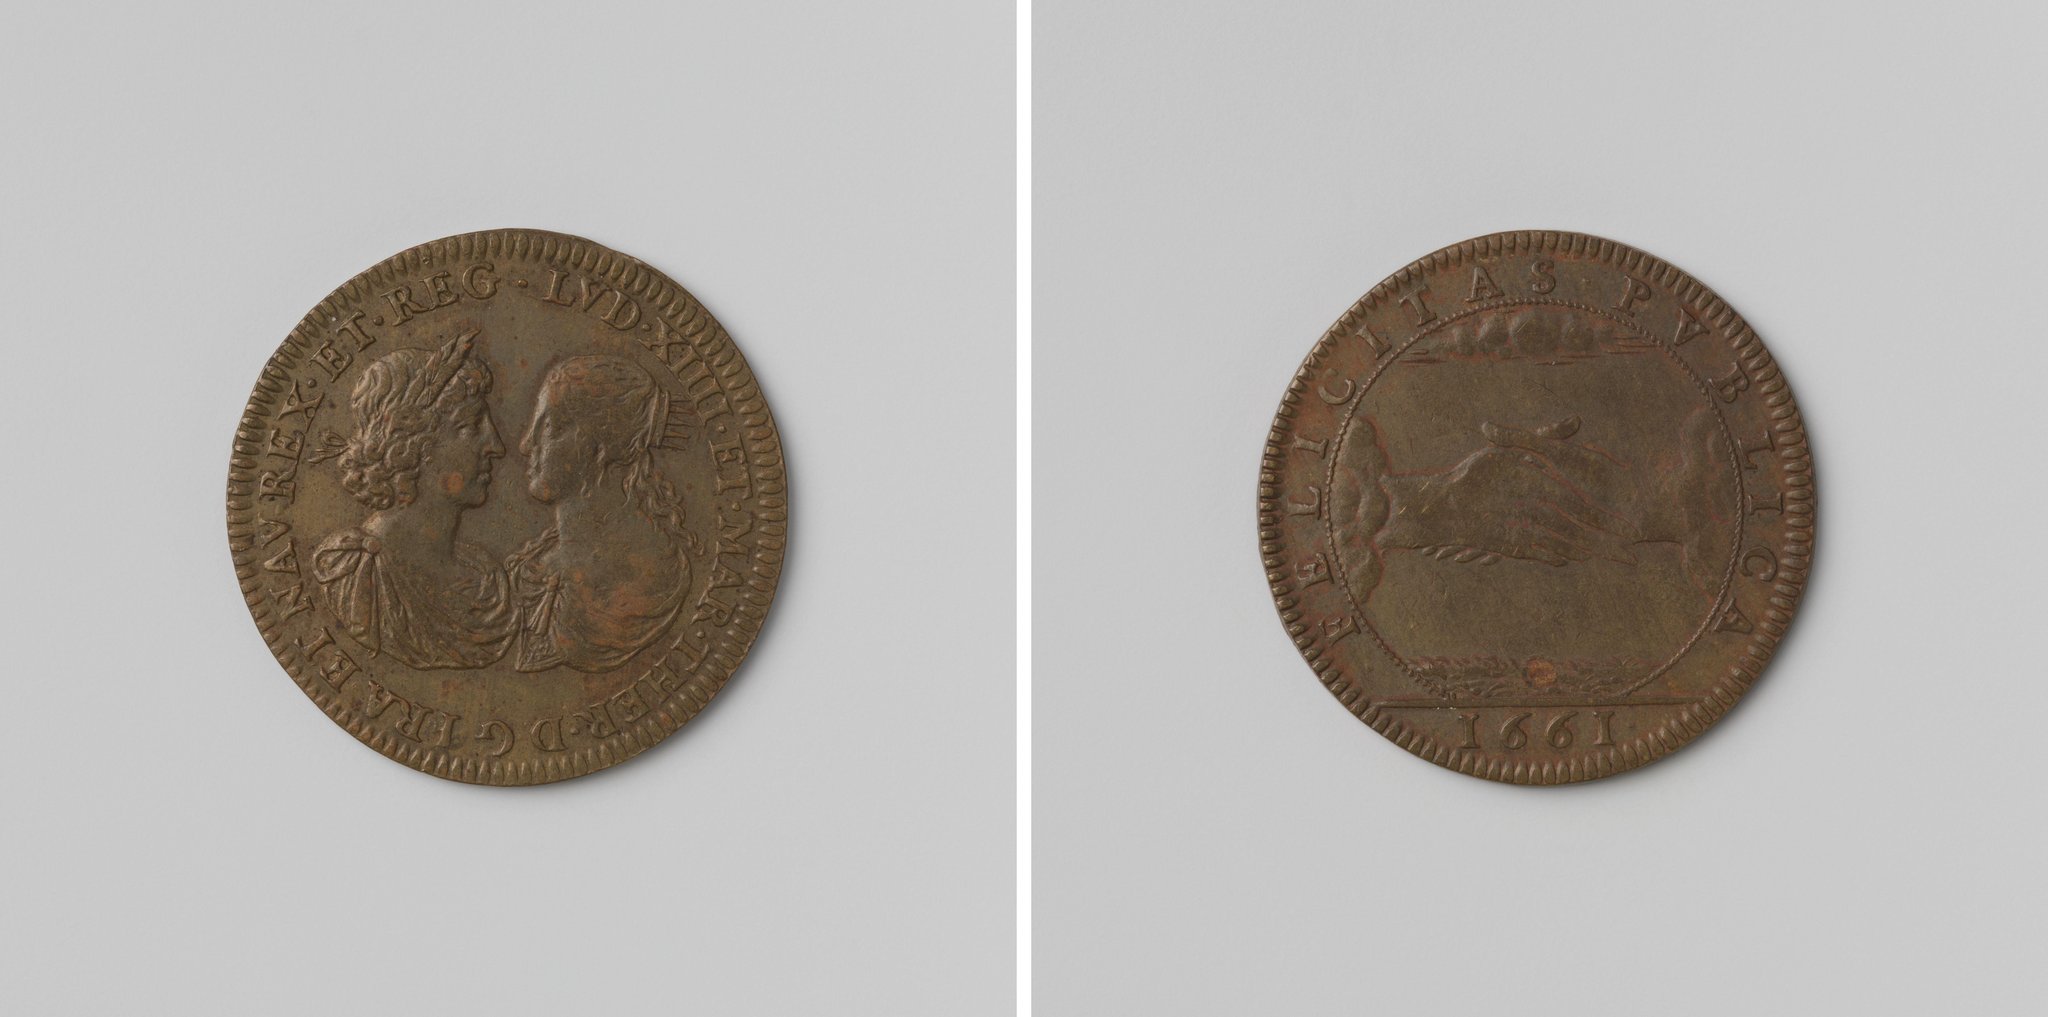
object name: jeton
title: Huwelijk van Lodewijk XIV en Maria Theresia, koning en koningin van Frankrijk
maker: Anonymous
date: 1661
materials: copper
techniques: striking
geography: paris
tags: lodewijk xiv (koning van frankrijk), maria theresia (koningin van frankrijk)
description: Koperen penning. Voorzijde: naar elkaar gewende borststukken van man met lauwerkrans en vrouw met kroon binnen omschrift. Keerzijde: twee ineen geslagen handen, beschenen door hemellicht binnen omschrift; afsnede: jaartal